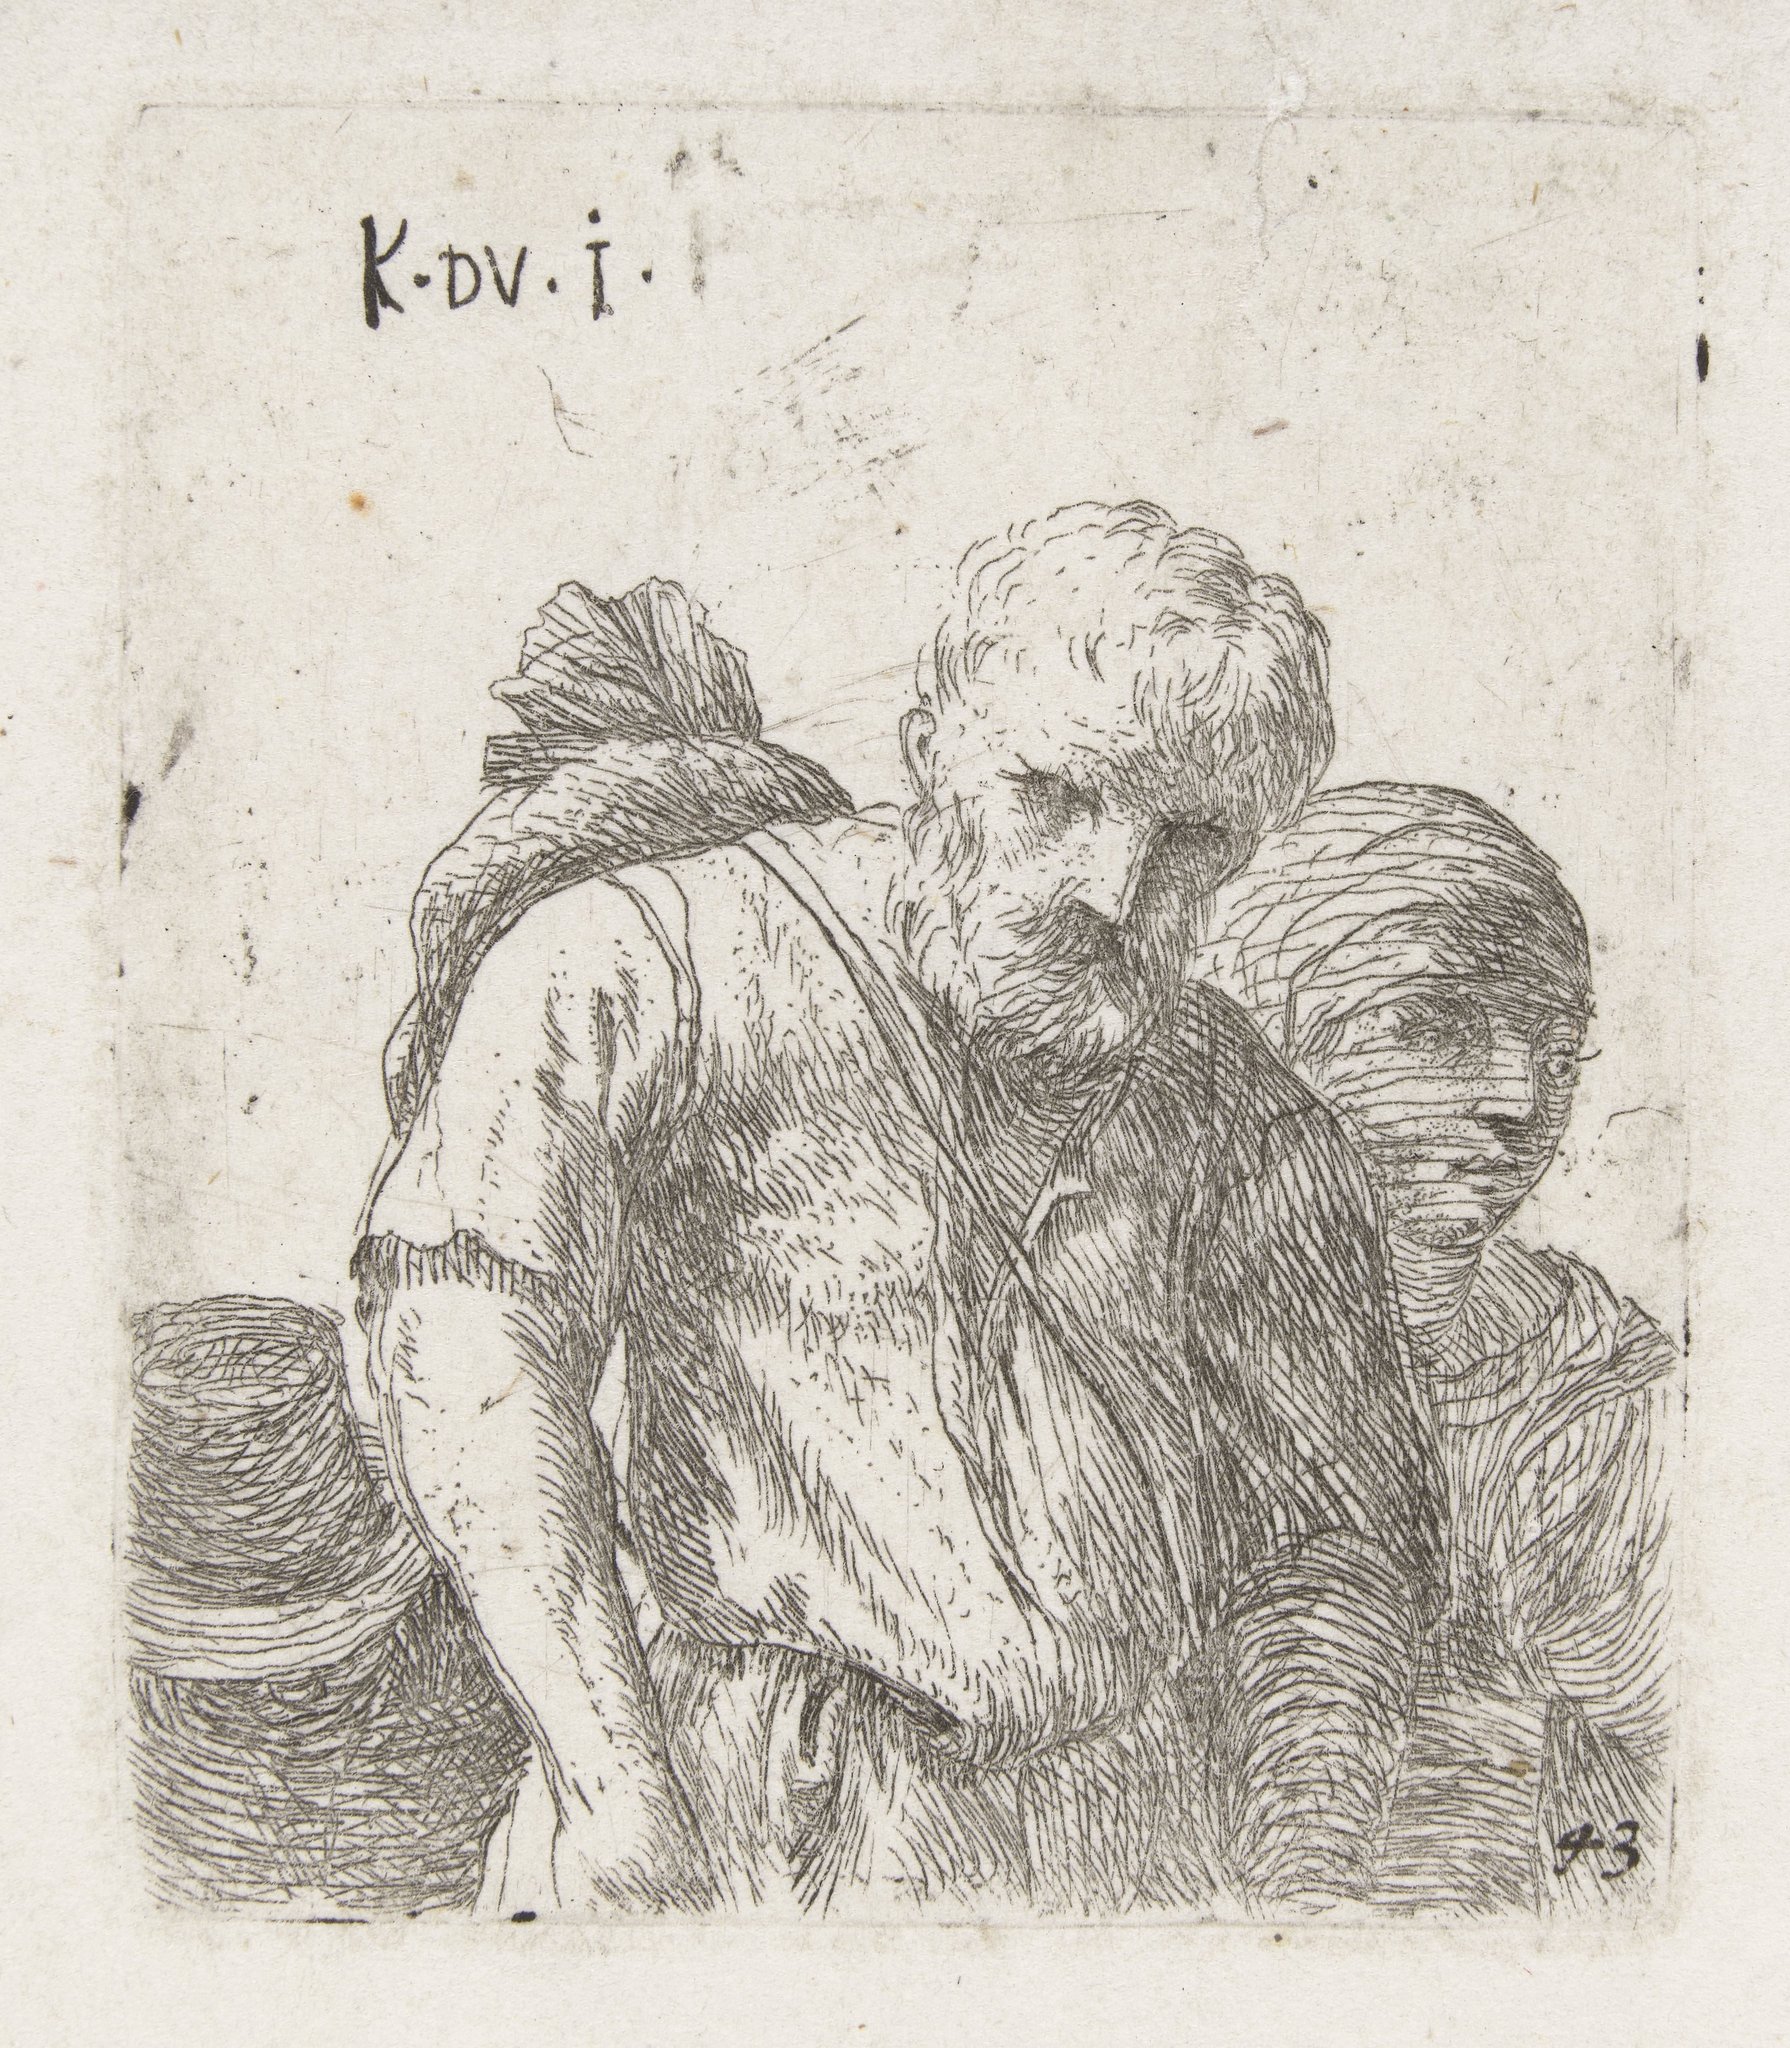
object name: print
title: Studieblad met hoofden en ruiter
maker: karel du jardin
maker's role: draughtsman, painter, print maker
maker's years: 1626-1678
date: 1652-1659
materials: paper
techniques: etching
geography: netherlands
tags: riding a horse, ass, or mule; rider, horseman, postures of the head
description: Maakt deel uit van blad met acht kleine etsen